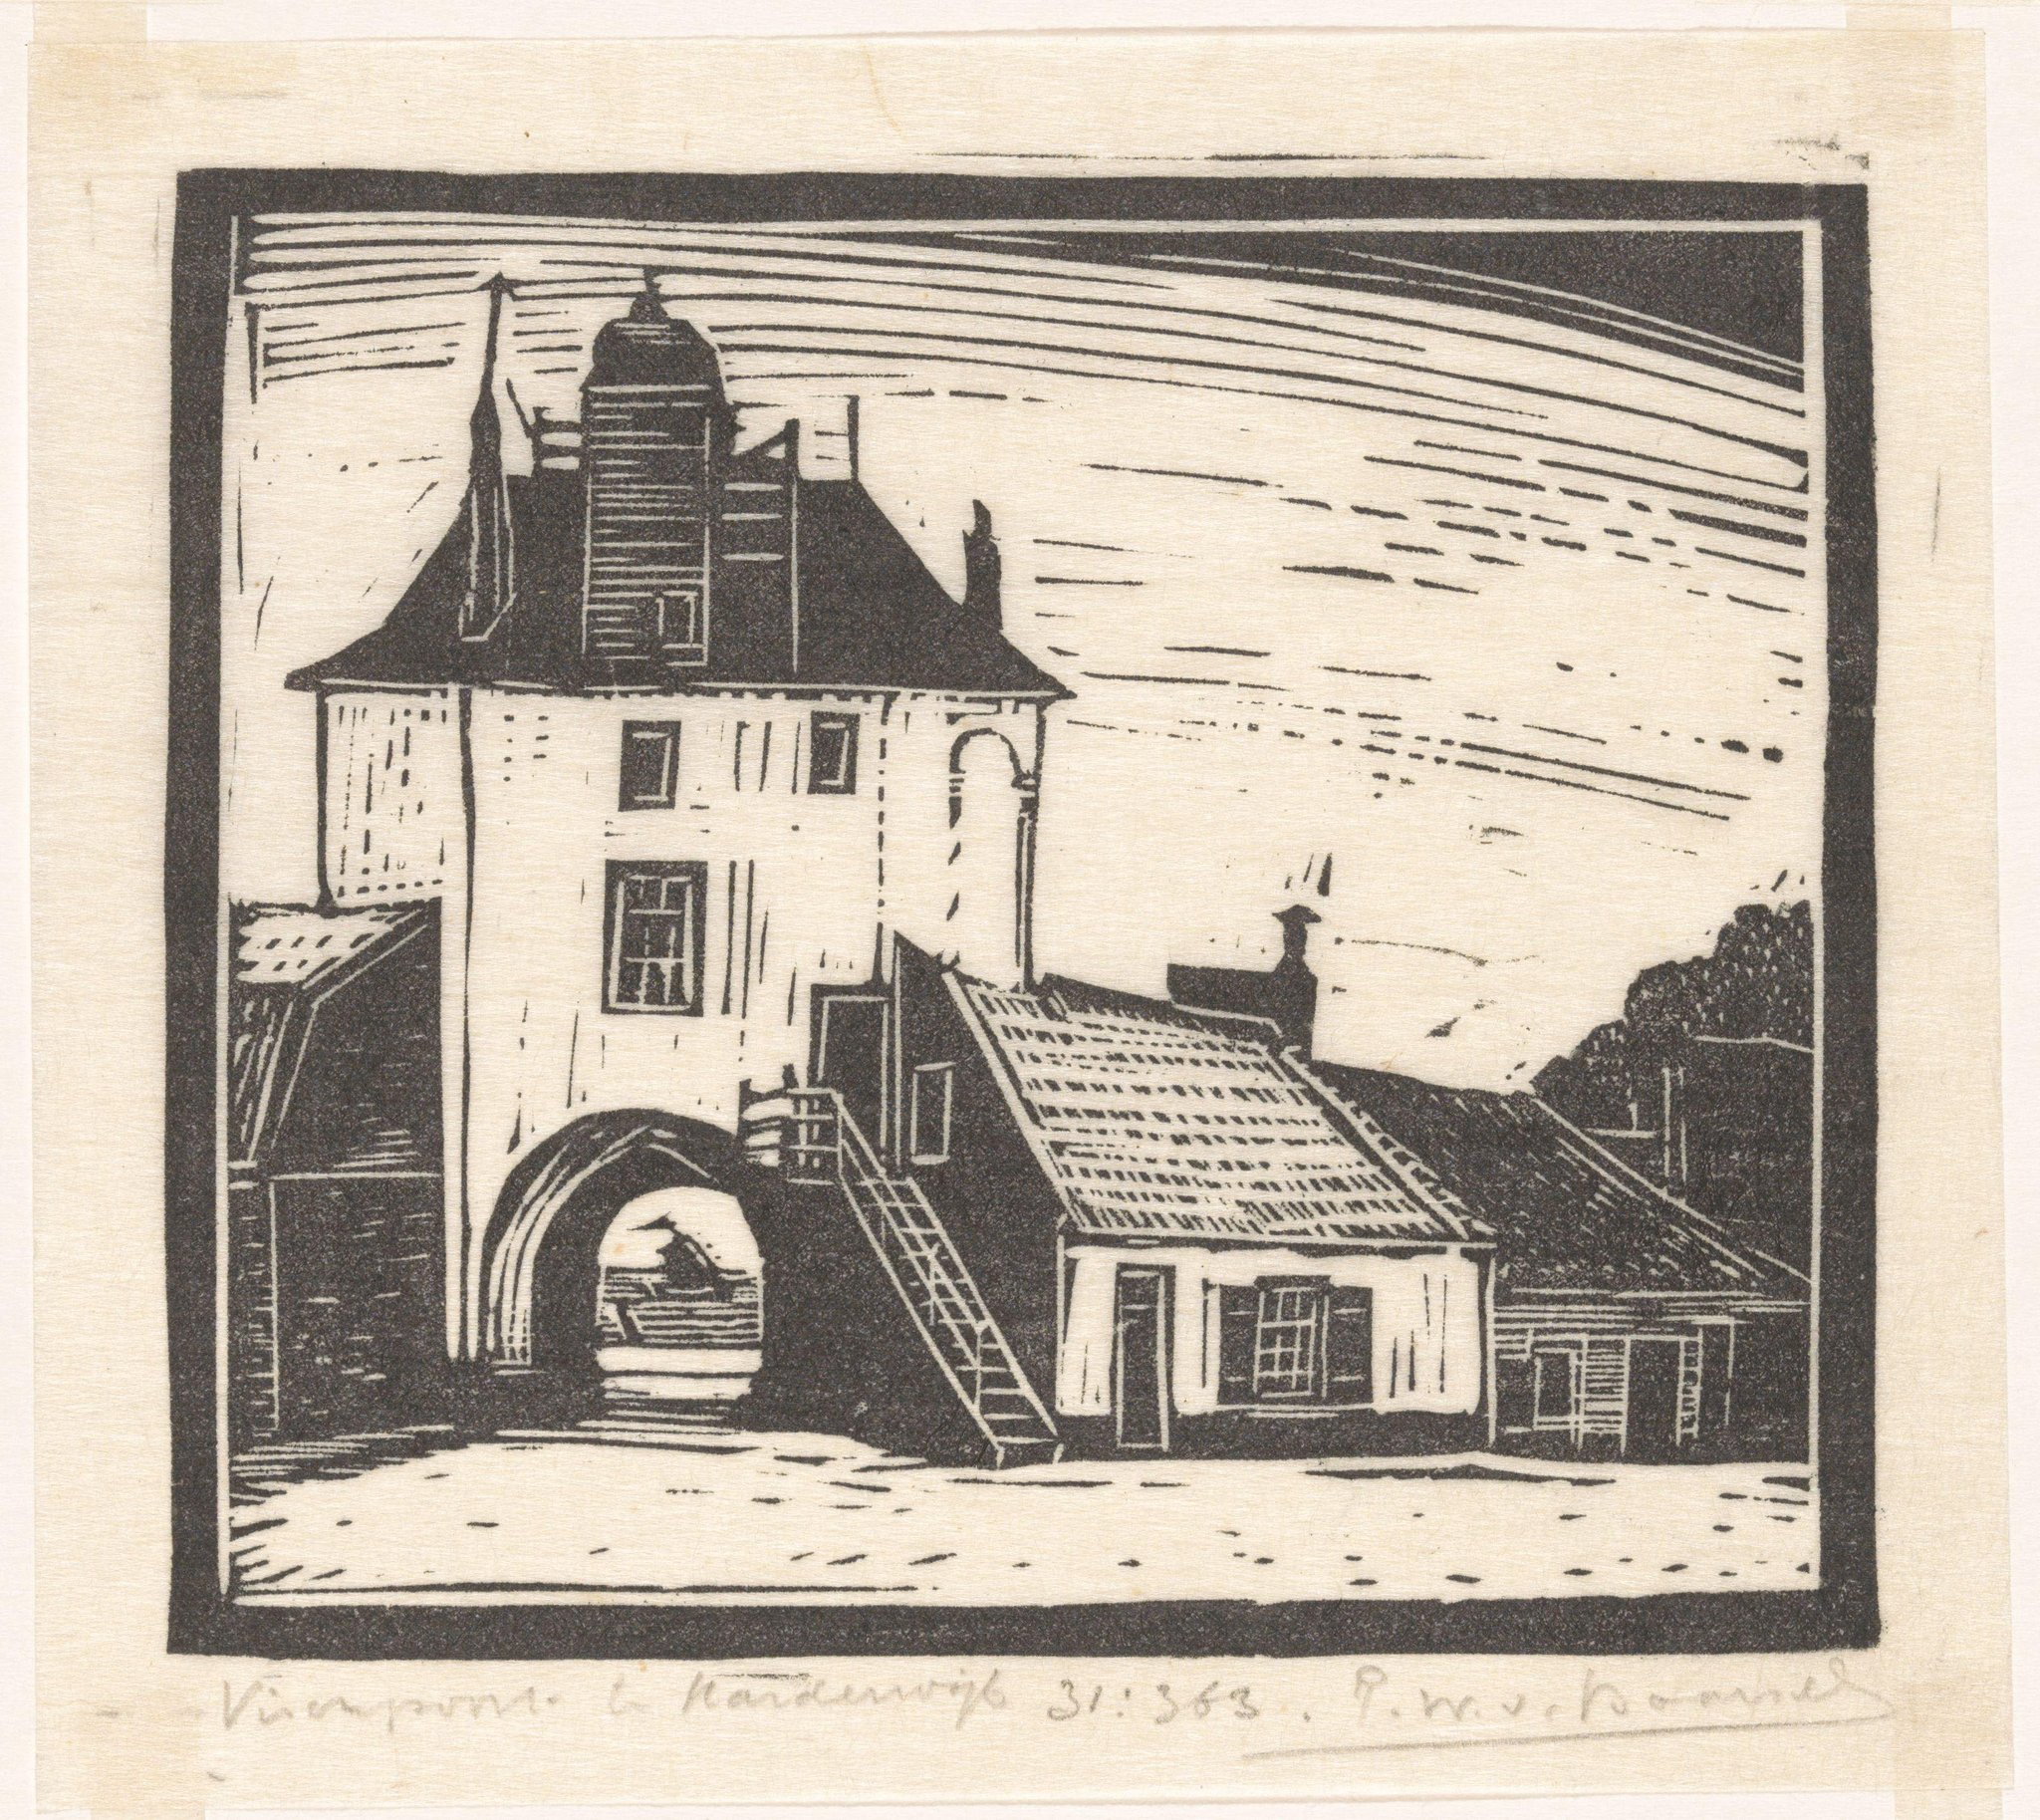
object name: print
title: Vischpoort te Harderwijk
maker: pieter willem van baarsel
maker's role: draughtsman, painter, print maker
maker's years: 1879-1949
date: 1889-1931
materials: paper, ink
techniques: woodcut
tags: harderwijk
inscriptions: signature: ‘P.W.v. Baarsel’, title: ‘Vischpoort te Harderwijk’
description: Gezicht op de Vischpoort van Harderwijk.